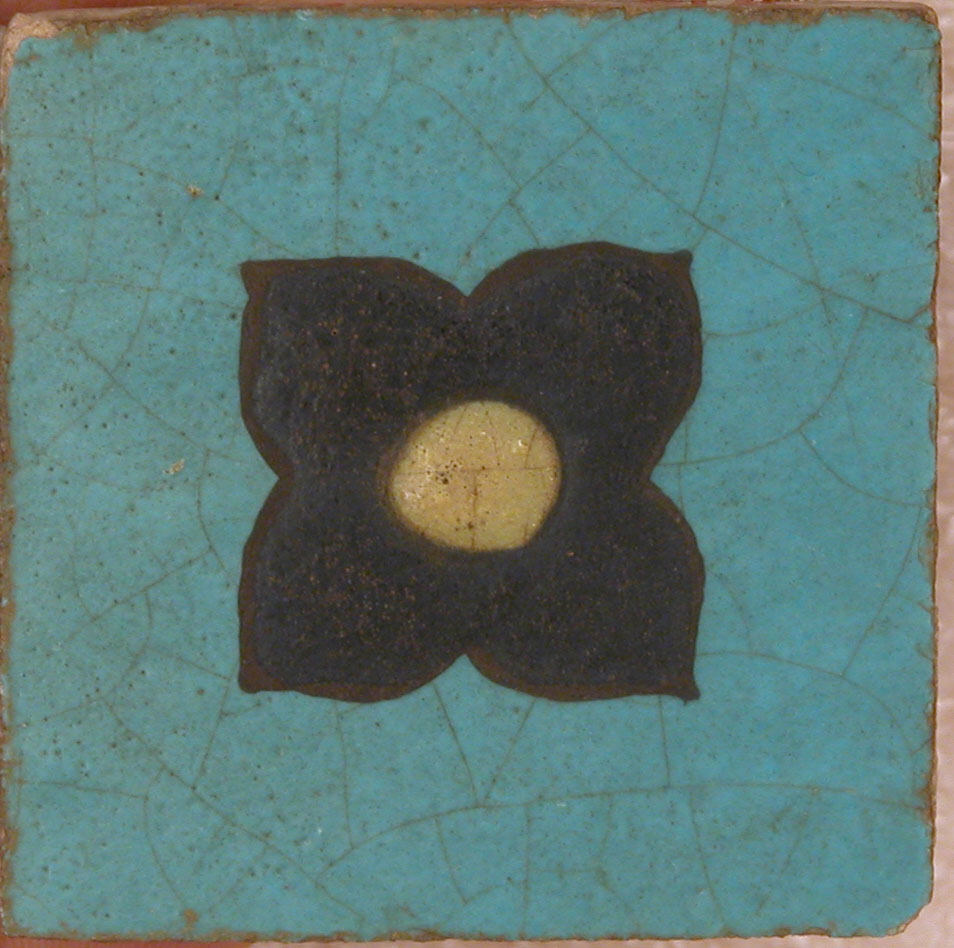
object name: tile fragment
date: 1334-1434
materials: glaze, stonepaste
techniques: painting, polychrome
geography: uzbekistan